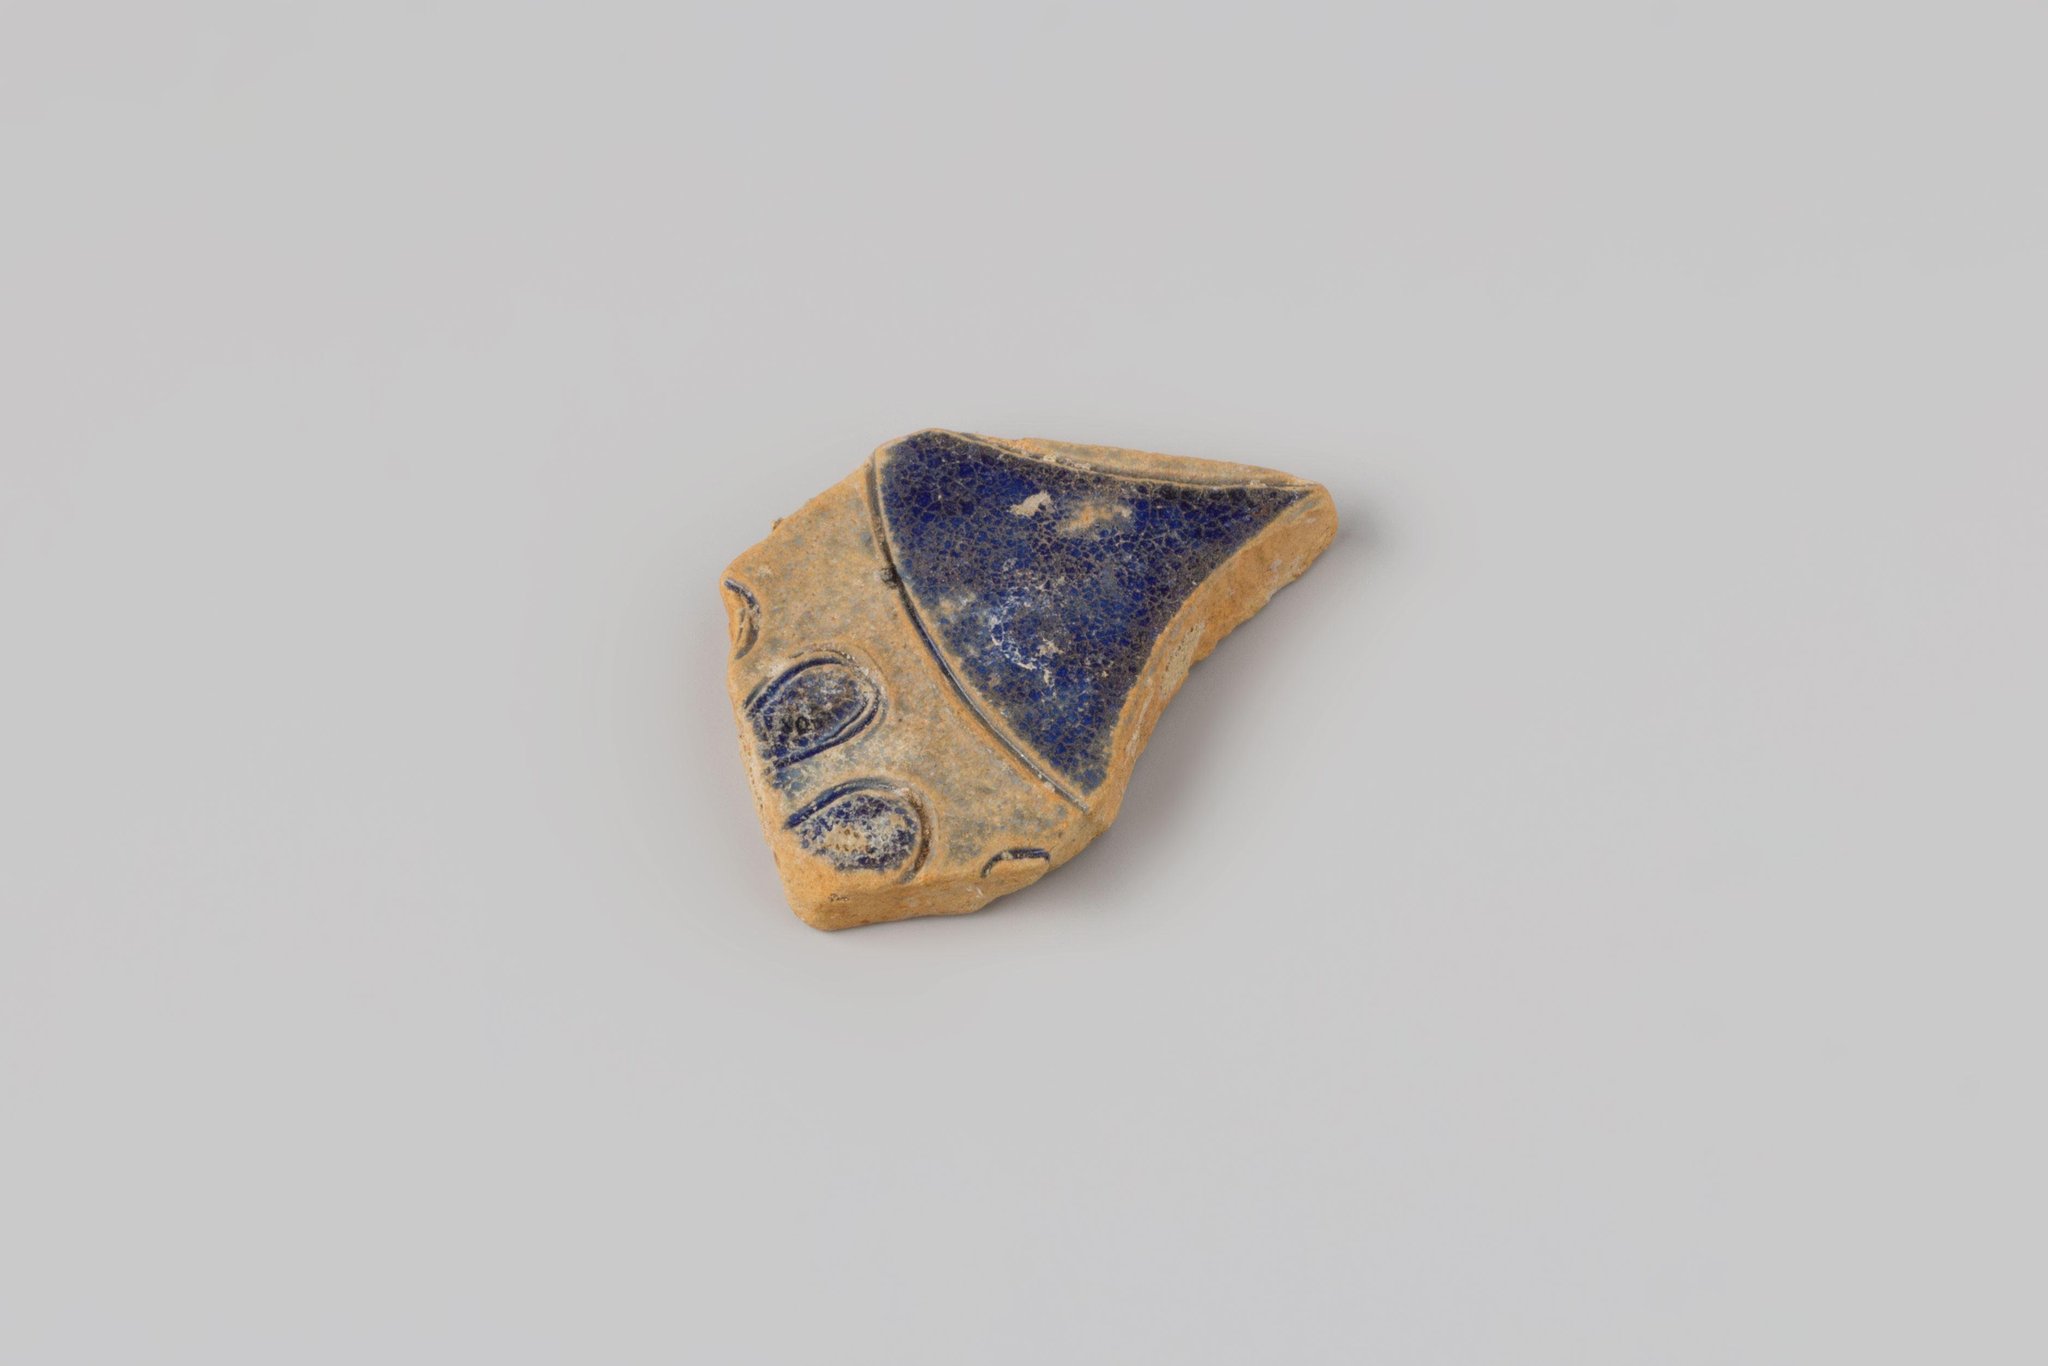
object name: pot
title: Scherf van een pot uit het wrak van de Oost-Indiëvaarder Hollandia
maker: Anonymous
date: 1700-1743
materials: stoneware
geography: westerwald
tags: verenigde oostindische compagnie, hollandia (schip), annet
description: Stoneware, Rhenish, Westerwald, pot; of body, sim. NG 1980-27H2624r.